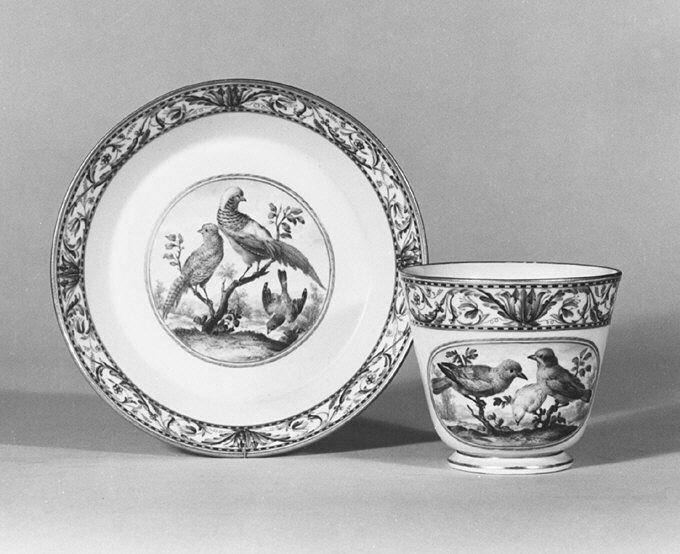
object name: saucer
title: Saucer (part of a service)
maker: meissen manufactory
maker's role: manufactory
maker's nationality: german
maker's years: 1710-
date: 1780-1785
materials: hard paste porcelain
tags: birds,plants